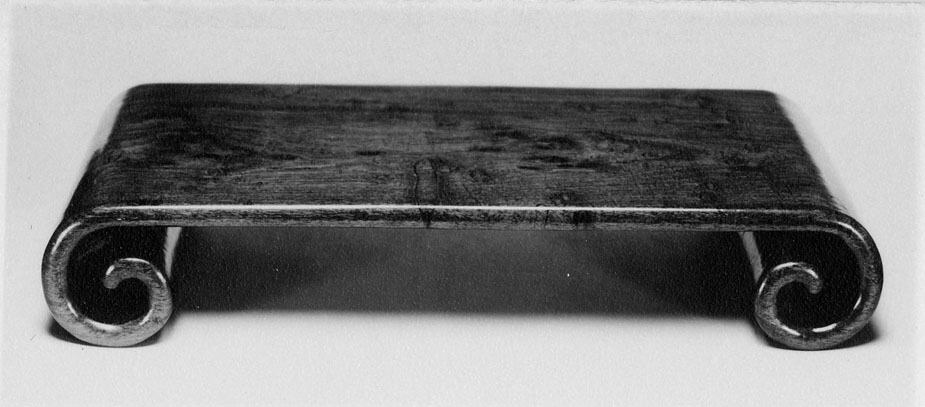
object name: couch table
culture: chinese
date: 1601-1700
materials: wood